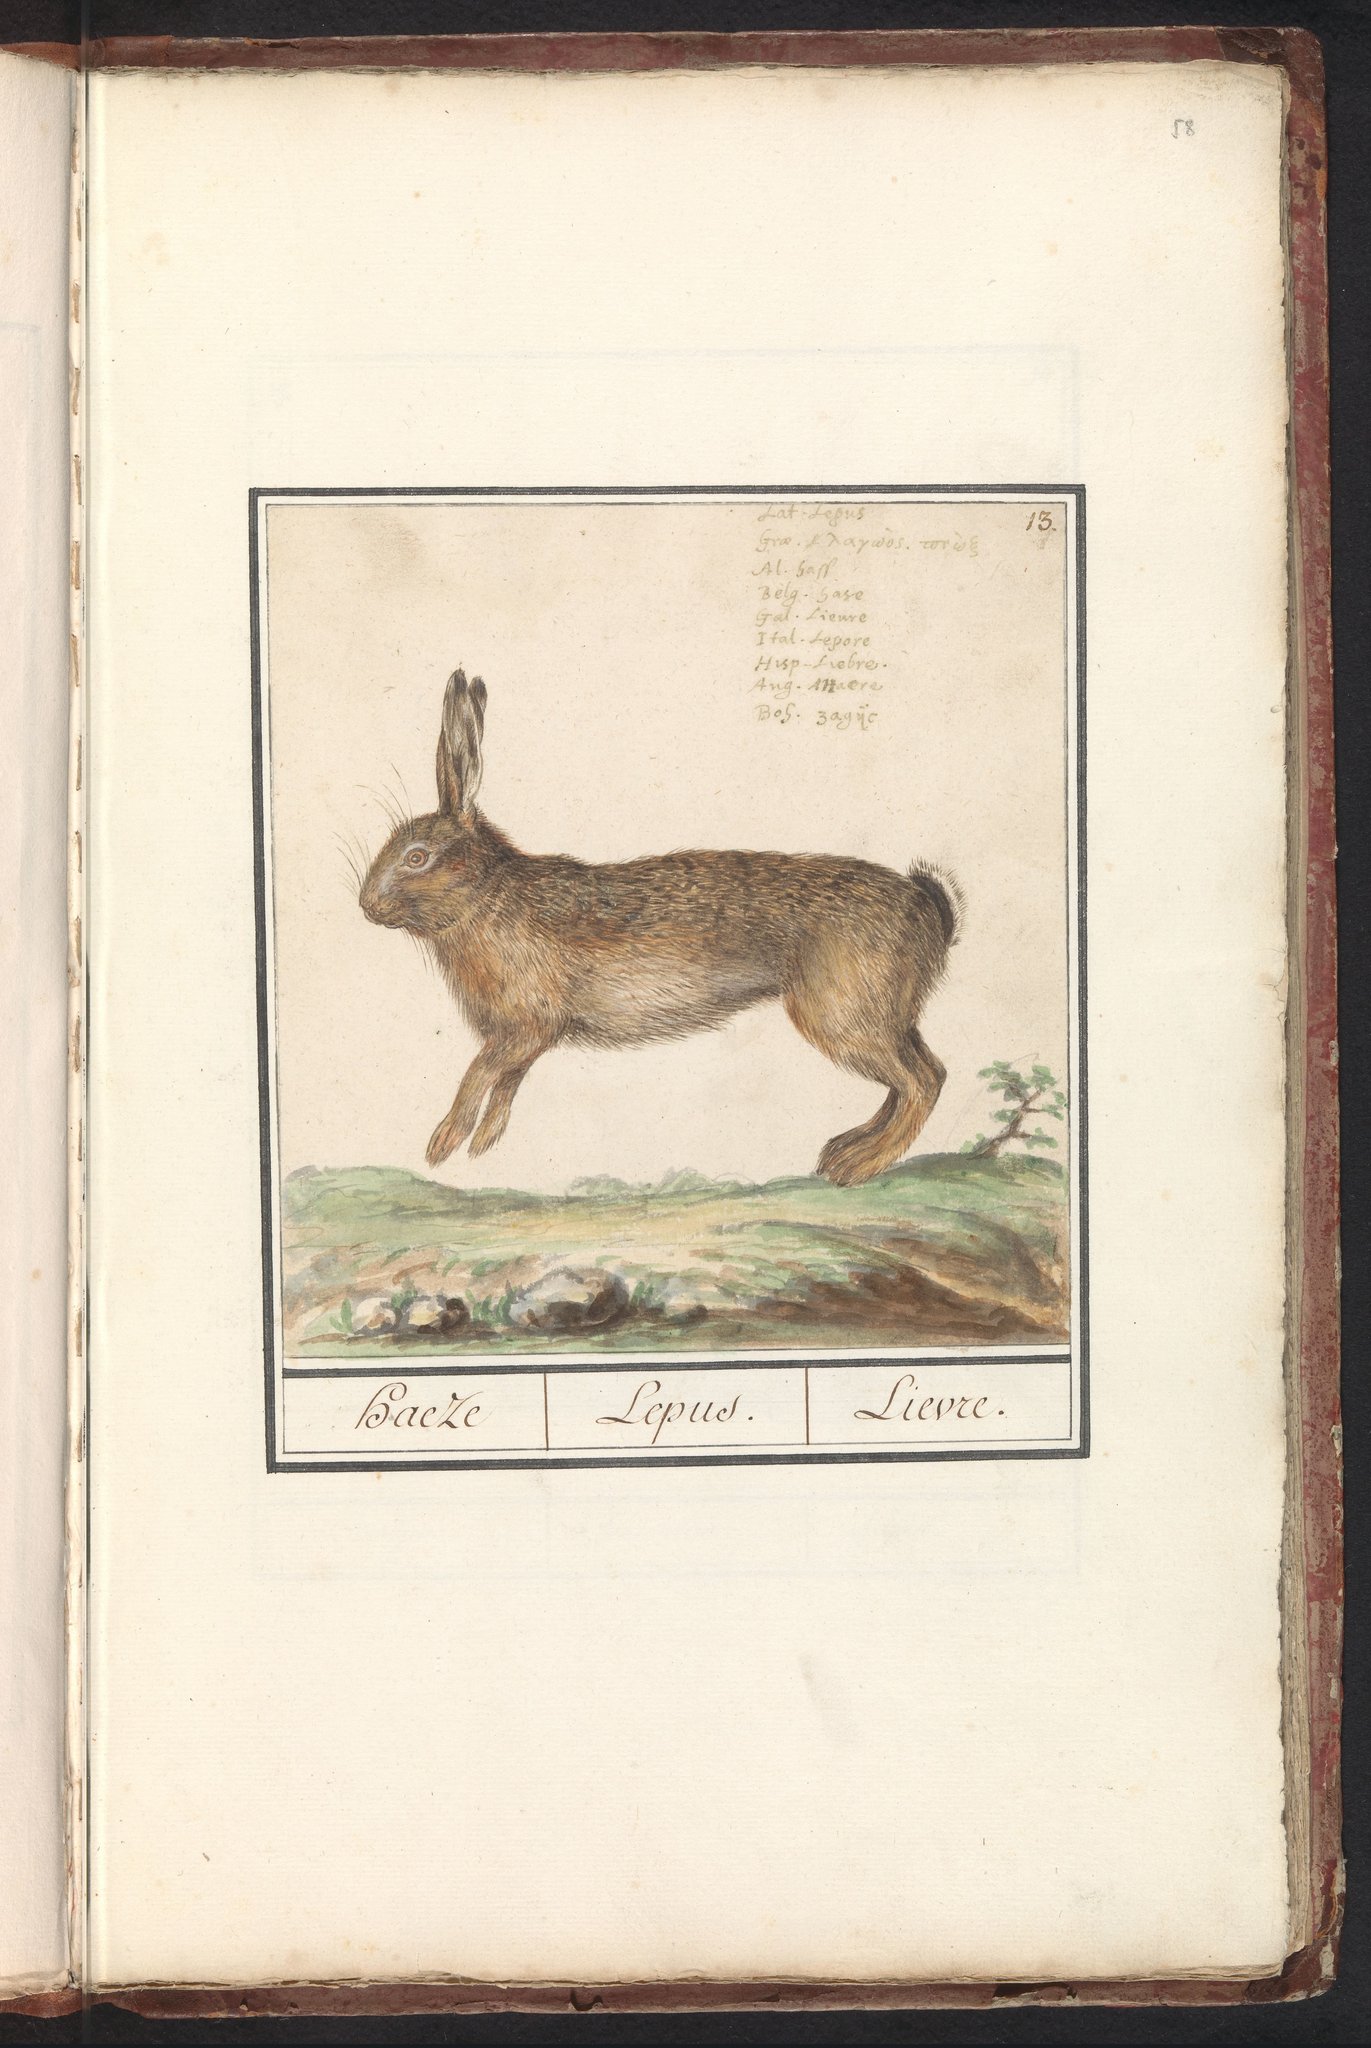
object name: drawing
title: European Hare (Lepus europaeus)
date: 1596-1610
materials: paint, ink, paper, watercolor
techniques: brush, pen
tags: rodents: hare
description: In the early 19th century, the mayor of Bruges, Van Huerne, had the Historia Naturalis rebound. The drawings were pasted onto pages provided with framing lines along with the name of each creature inscribed in the Dutch, Latin and French forms of the time. Additionally, he commissioned artists to enhance the drawings by adding surrounding details and backgrounds. As a result, the portrayal of the hare in mid-jump creates the illusion that it is floating above the grass.